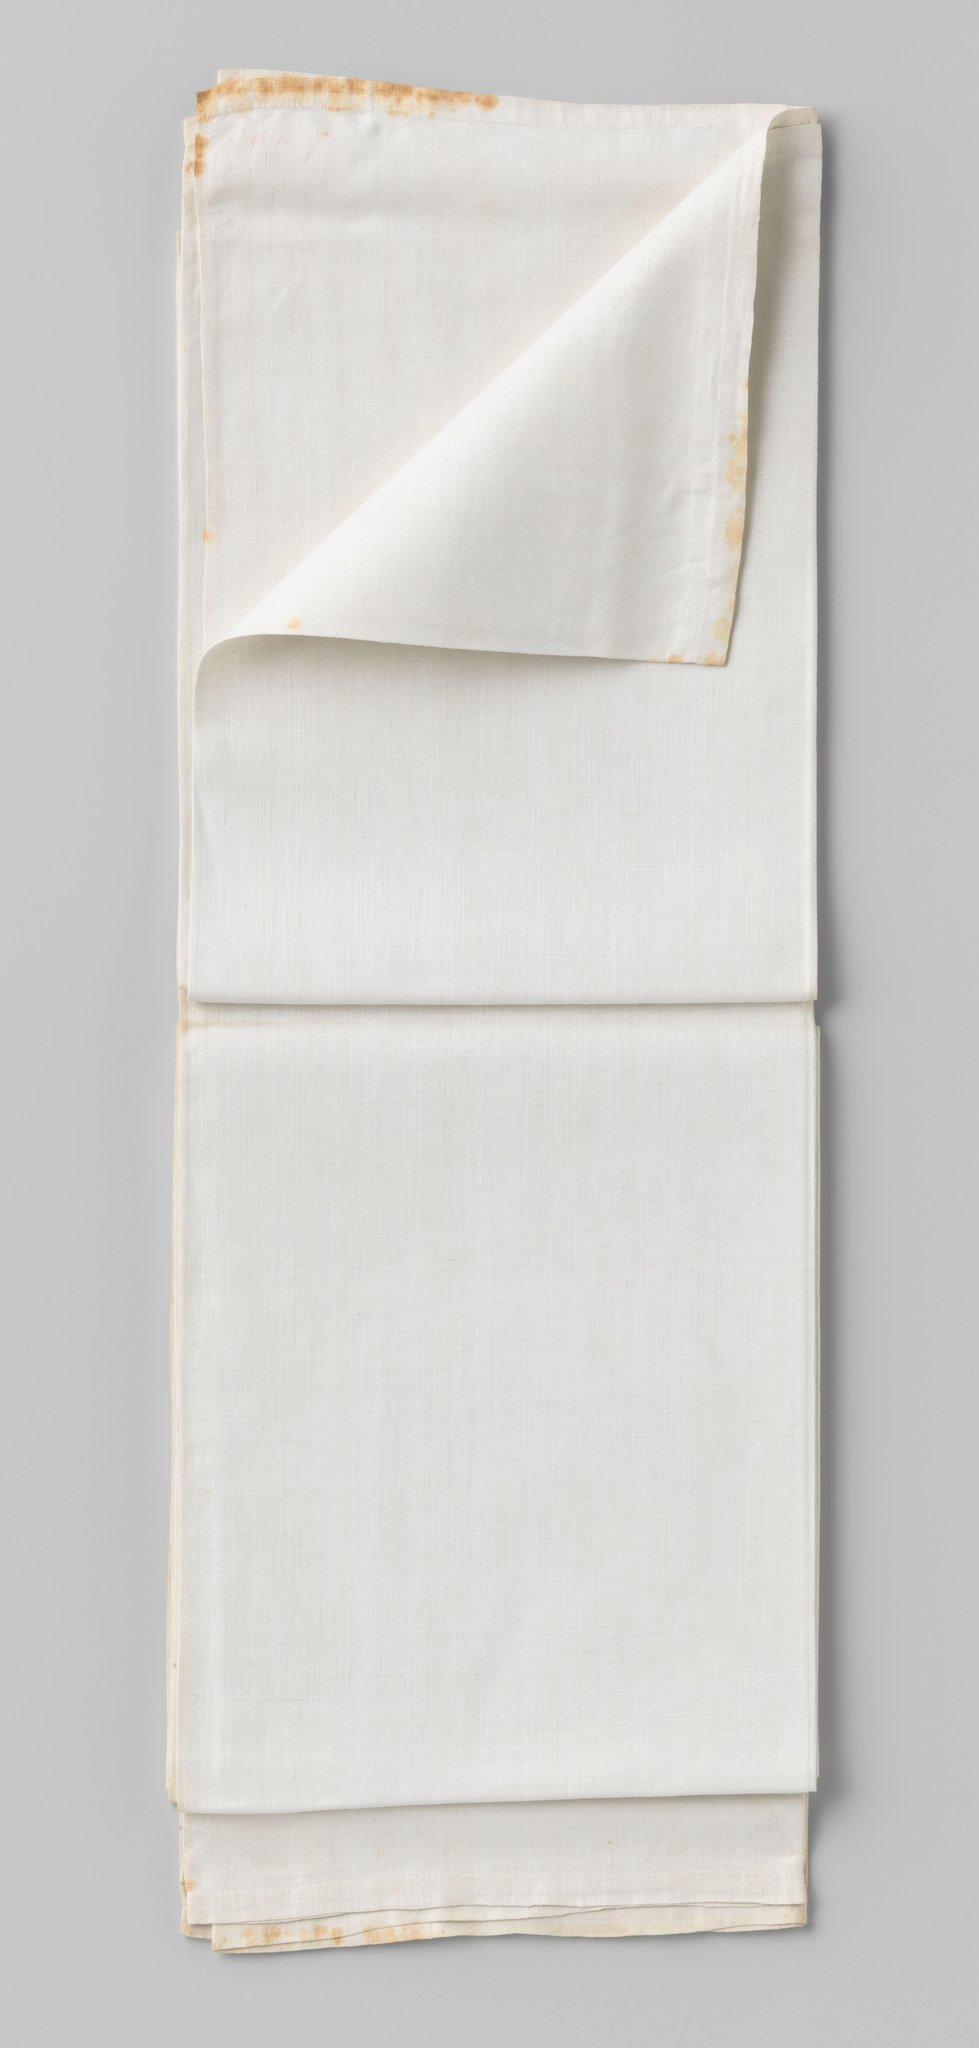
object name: beddenlaken, laken object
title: Kinderlaken. Merk: HW 18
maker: Anonymous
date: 1852-1860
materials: linen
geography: northern netherlands